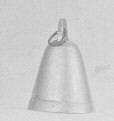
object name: bell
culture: european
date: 1801-1900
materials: metal